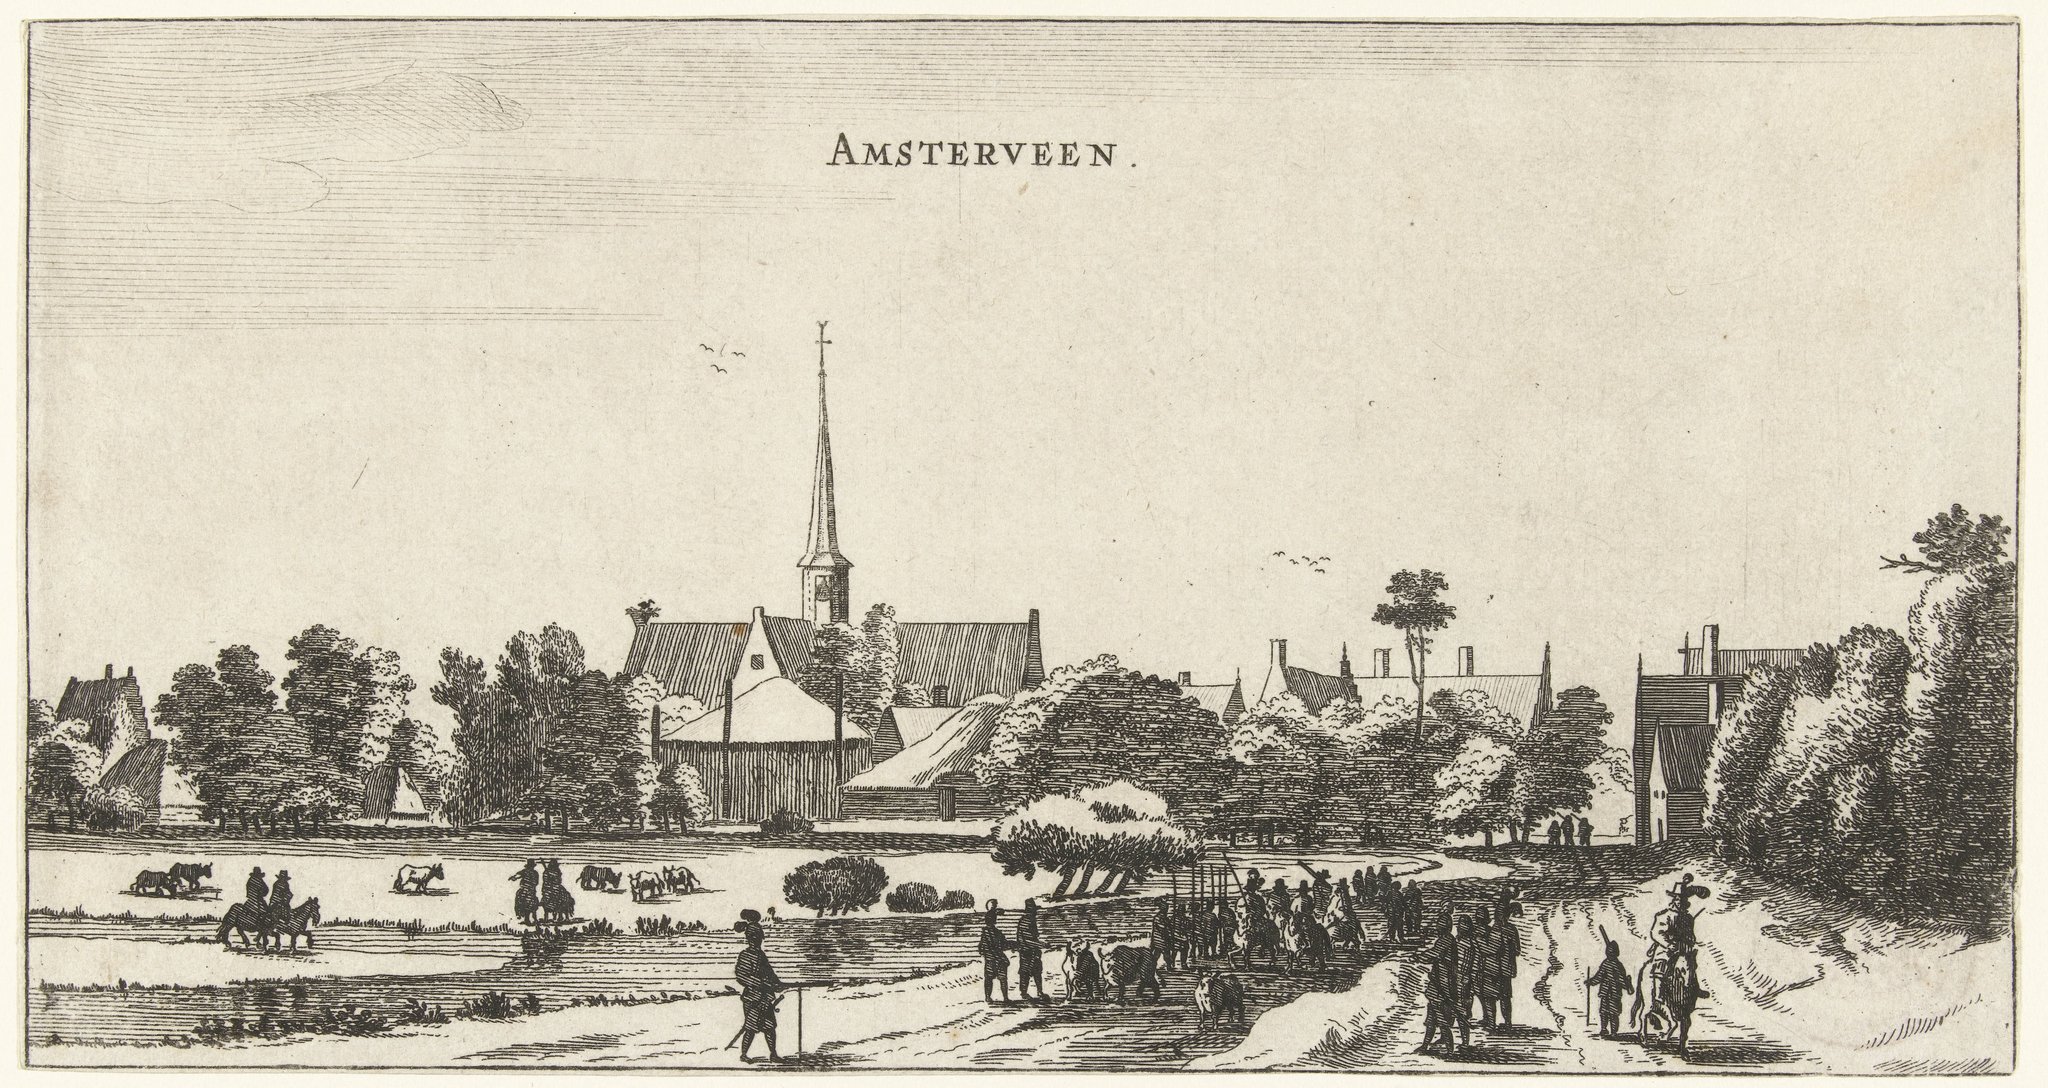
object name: print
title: Amstelveen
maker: Anonymous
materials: paper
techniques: etching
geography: northern netherlands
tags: william ii (prince of orange)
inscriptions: collector's mark: Lugt 240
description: Gezicht te Amstelveen. Onderdeel van een serie van zes gezichten in de dorpen waar de troepen van prins Willem II ingekwartierd lagen tijdens het beleg van Amsterdam, van 30 juli tot 4 augustus 1650.